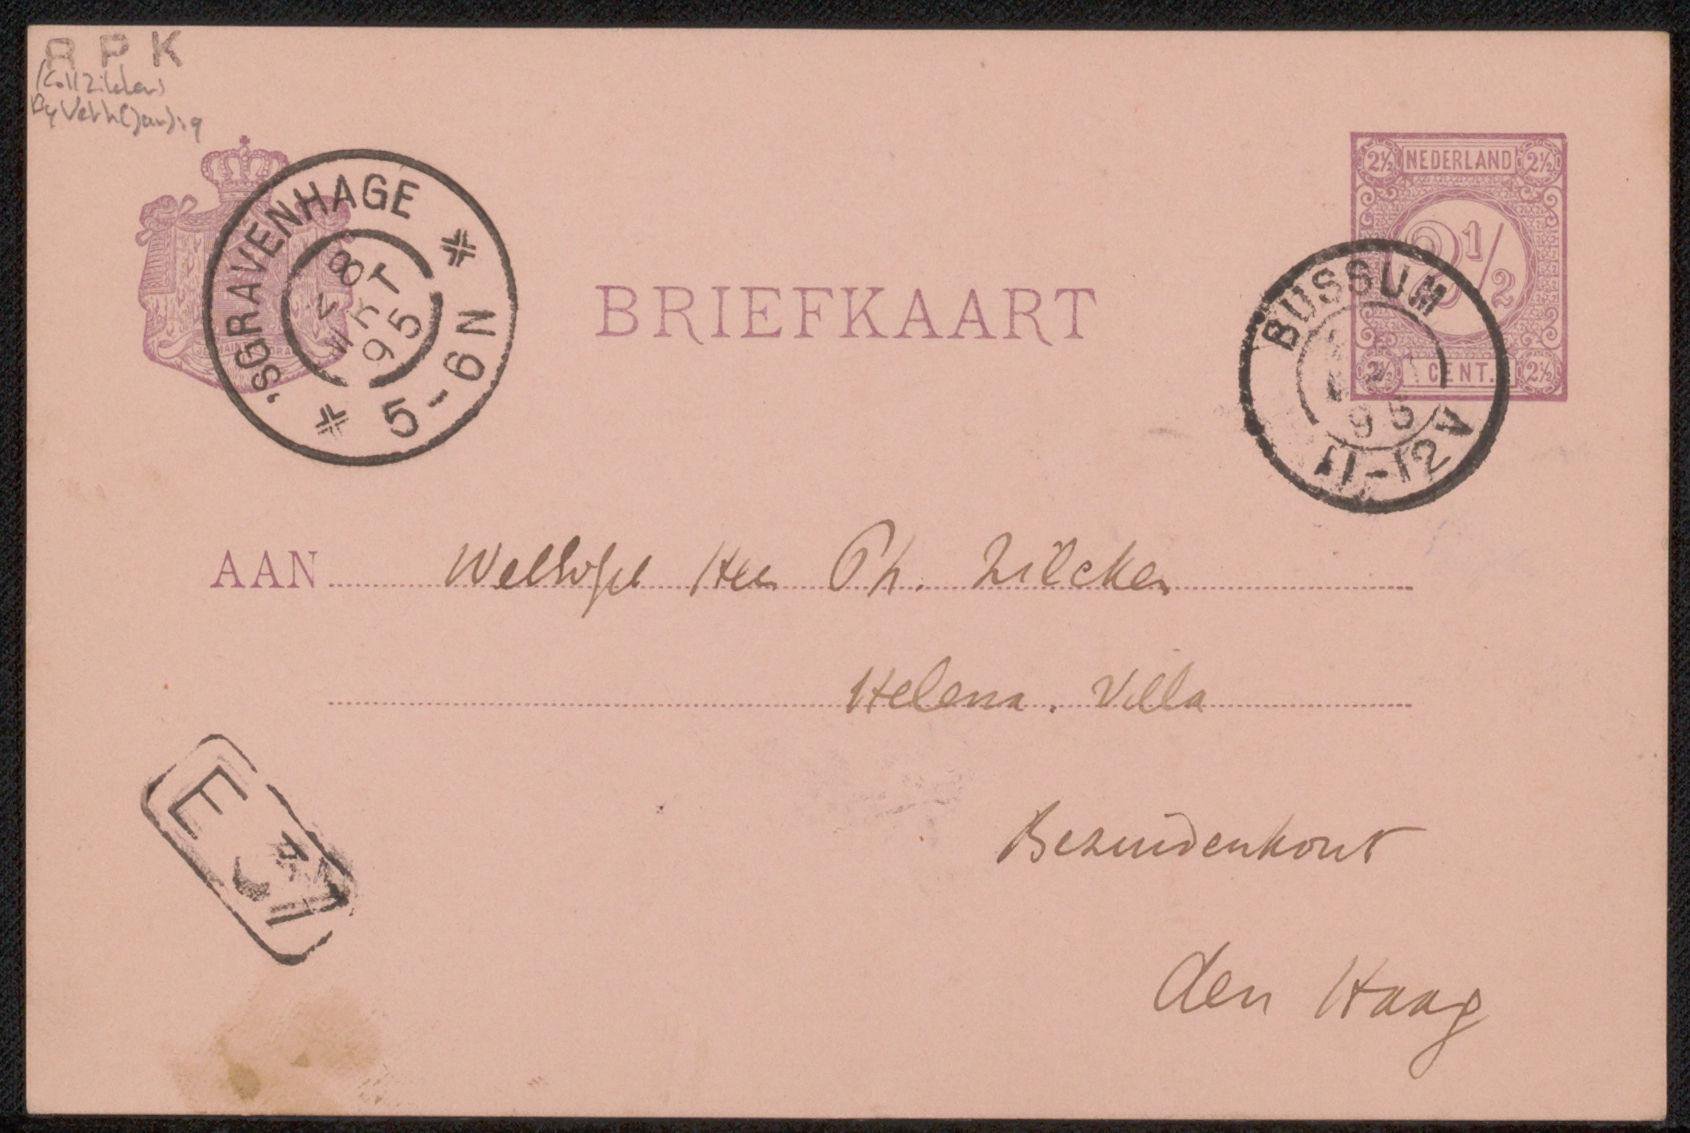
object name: postcard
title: Briefkaart aan Philip Zilcken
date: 1895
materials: cardboard, ink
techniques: pen, writing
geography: bussum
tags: the hague, philip zilcken, exhibition ~ art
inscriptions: collector's mark: ‘RPK’